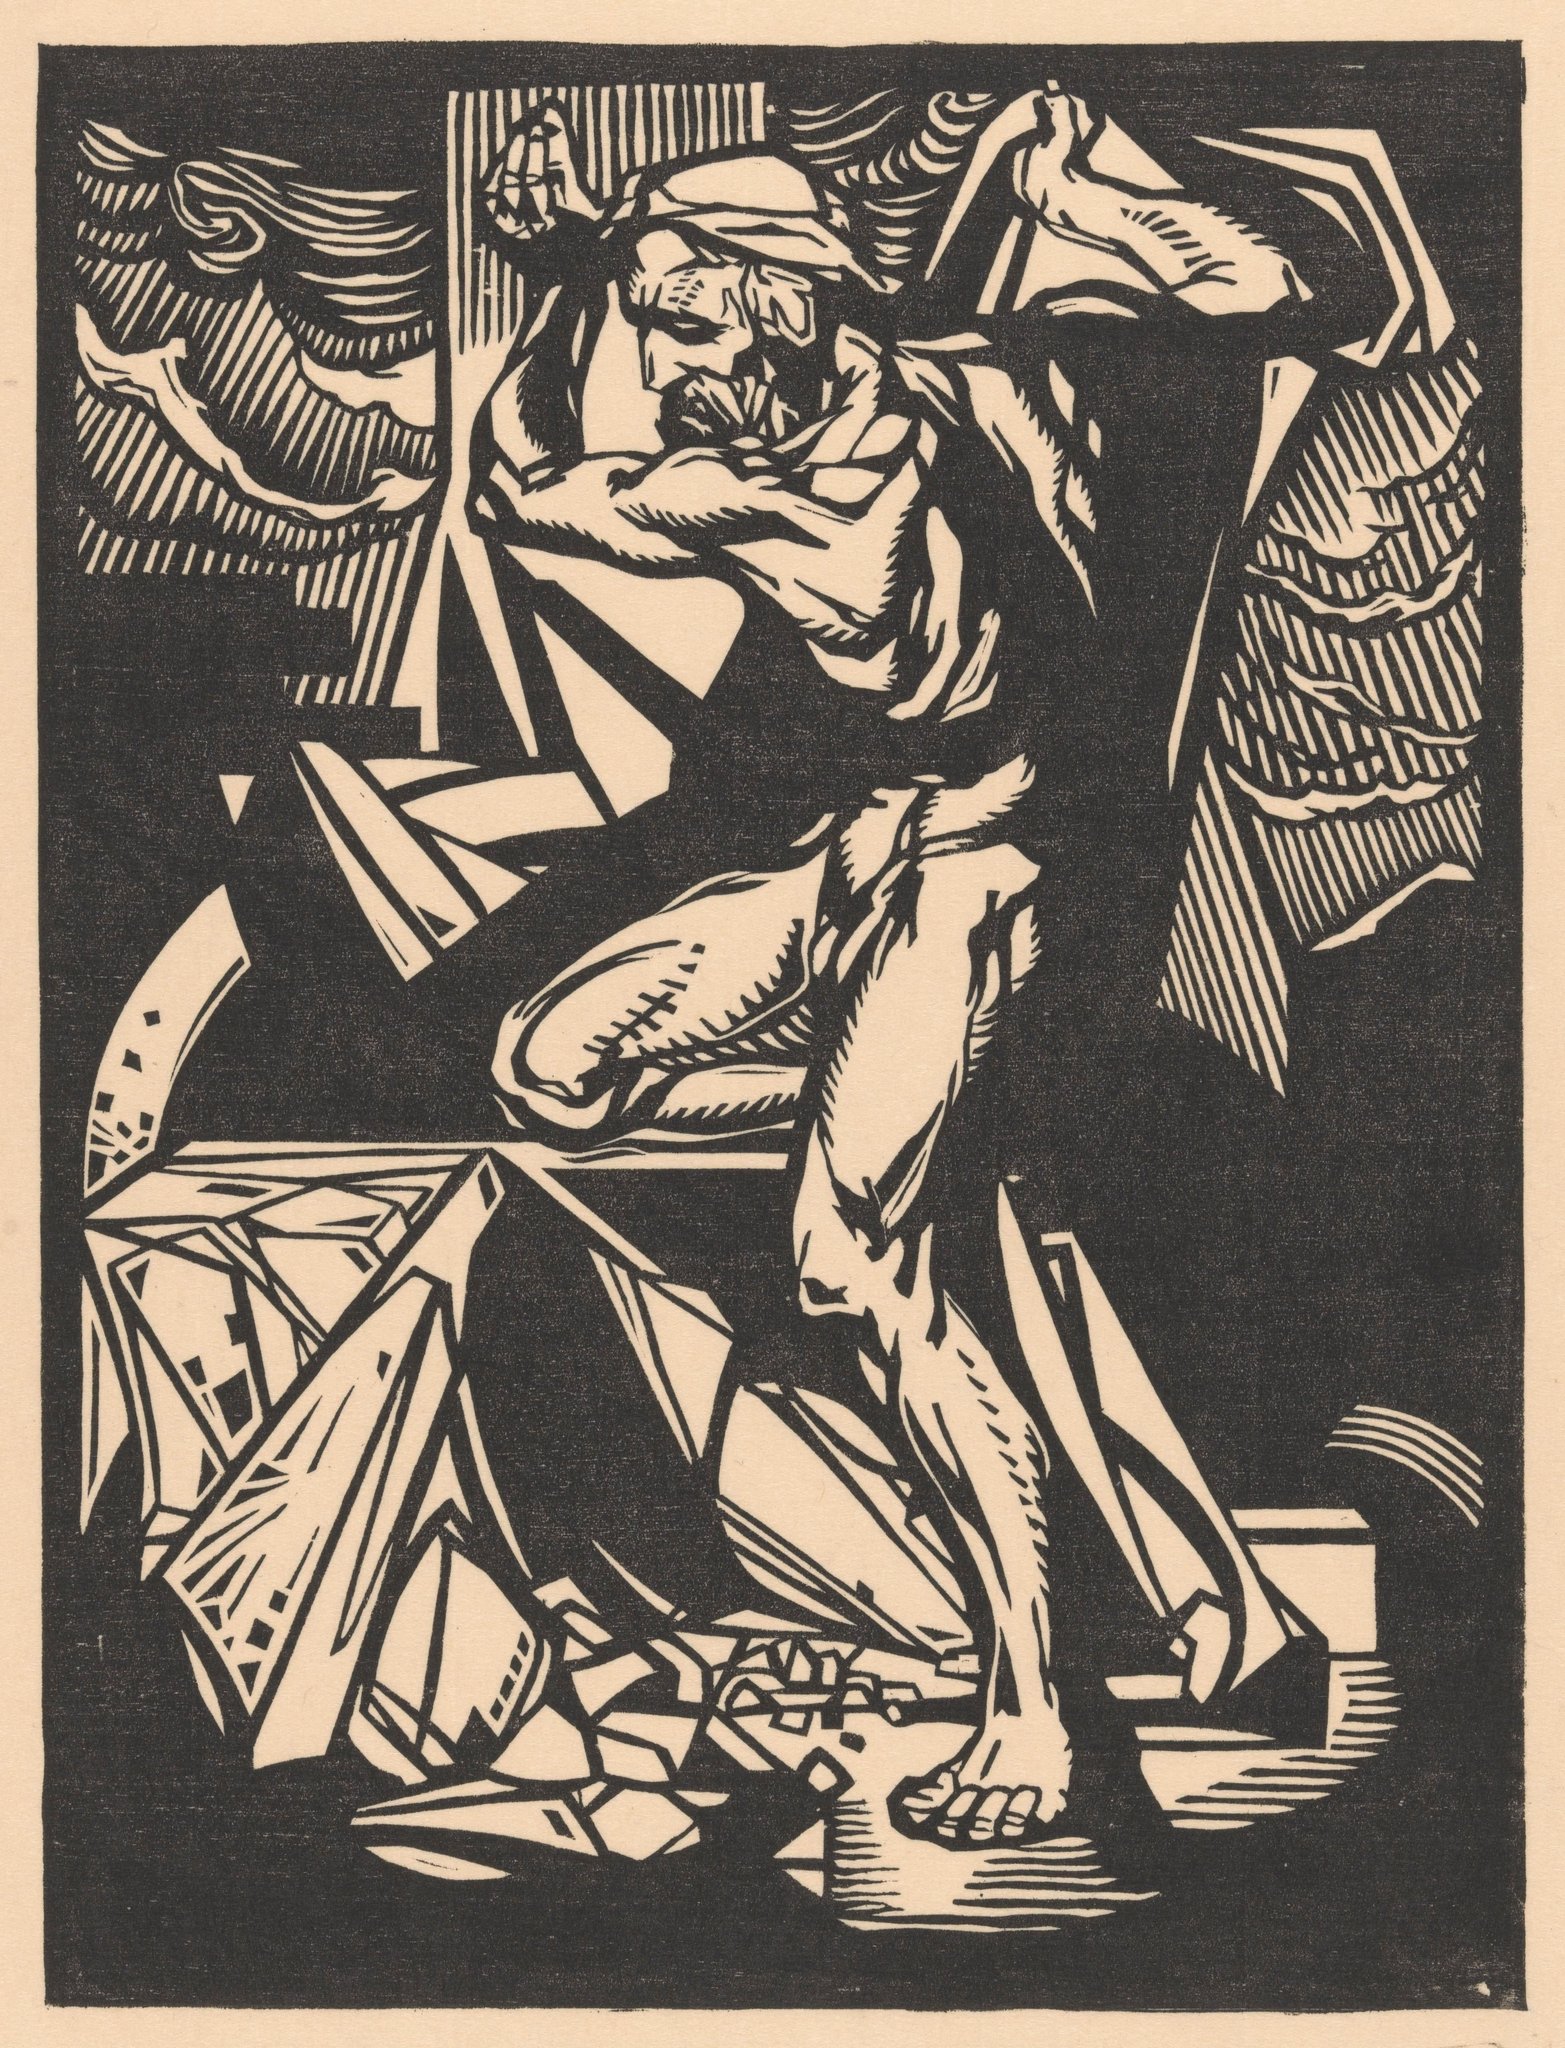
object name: print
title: Simson vernielt de zuilen van de tempel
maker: johannes josephus aarts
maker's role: draughtsman, print maker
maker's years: 1871-1934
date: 1881-1934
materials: paper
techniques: woodcut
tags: samson breaks the pillars; the temple of dagon collapses, killing all that are in it, man (showing himself) undressed, quasi-nude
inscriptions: collector's mark: Lugt 2228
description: Simson trekt twee zuilen van de tempel van de Filistijnen omver, waardoor het gebouw instort en alle aanwezigen, inclusief Simson, worden gedood.